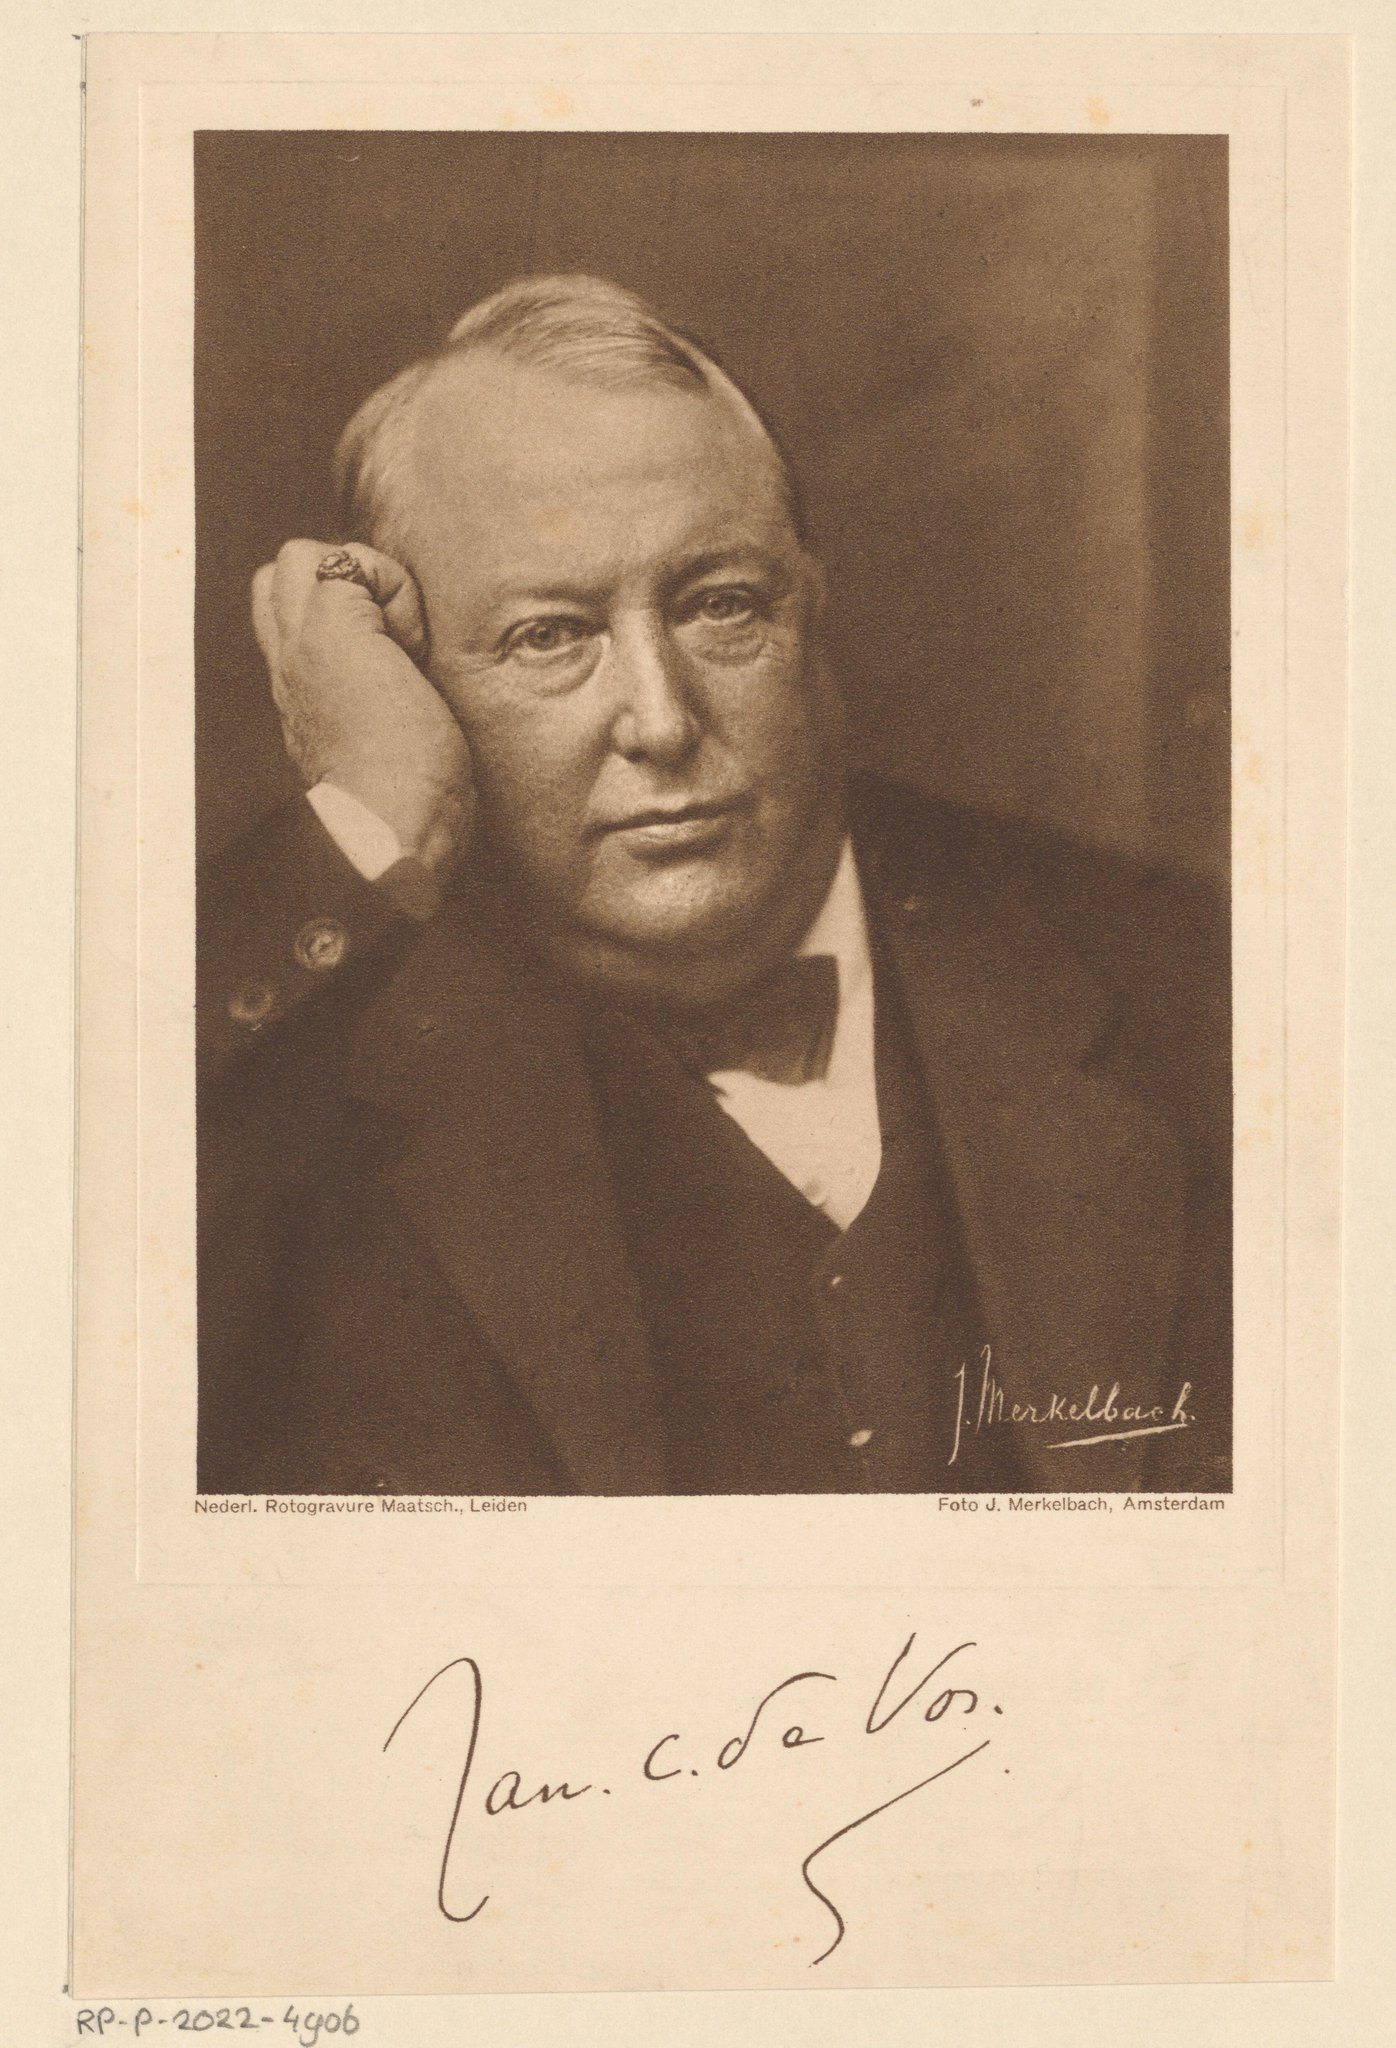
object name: photomechanical print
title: Portret van Jan Cornelis de Vos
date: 1910-1933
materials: paper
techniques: rotogravure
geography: leiden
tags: portrait of artiste (dancer, actor, etc.), director, producer ~ the stage, historical persons